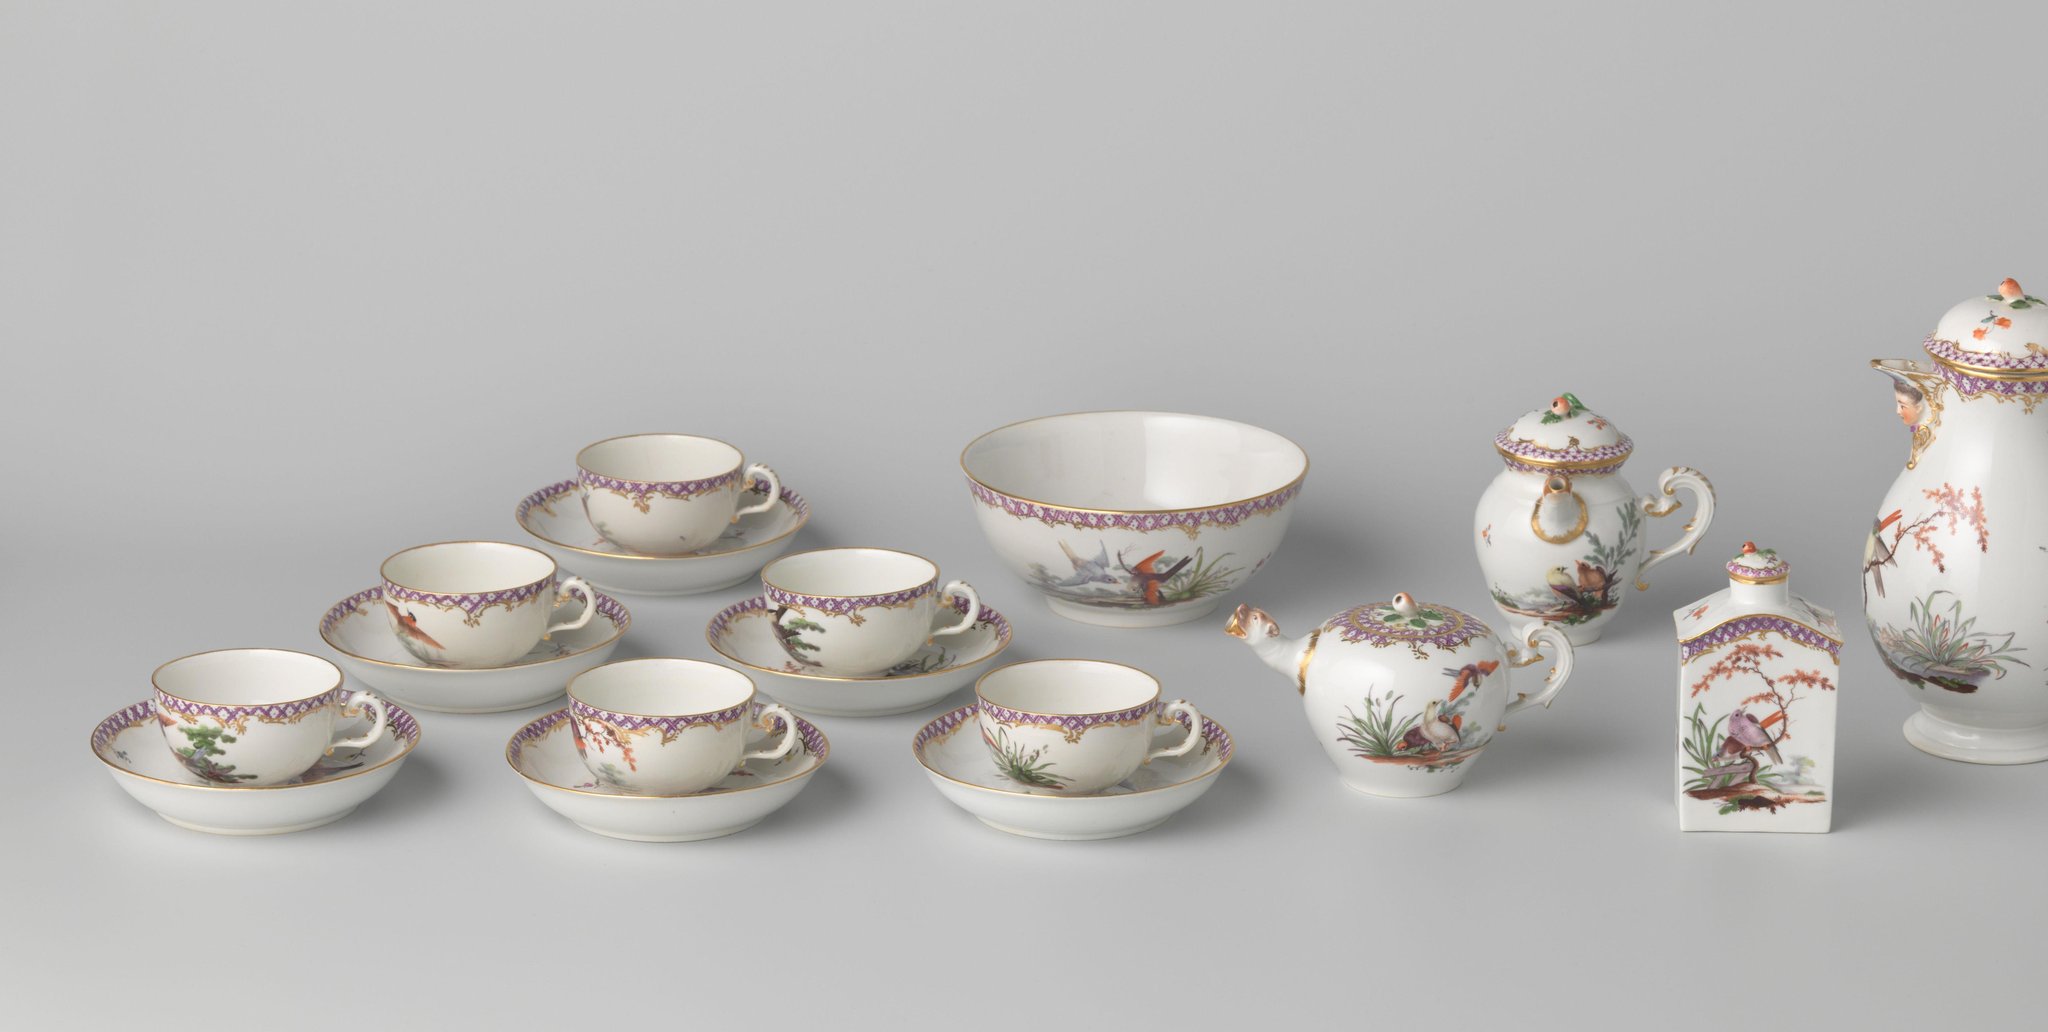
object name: coffee service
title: Coffee and tea service with birds in a landscape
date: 1765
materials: glaze, gold, paint, porcelain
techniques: firing, forming, gilding, turning, vitrification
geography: ansbach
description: Tea and coffee service. Porcelain. Ansbach, c. 1760 - 1770.